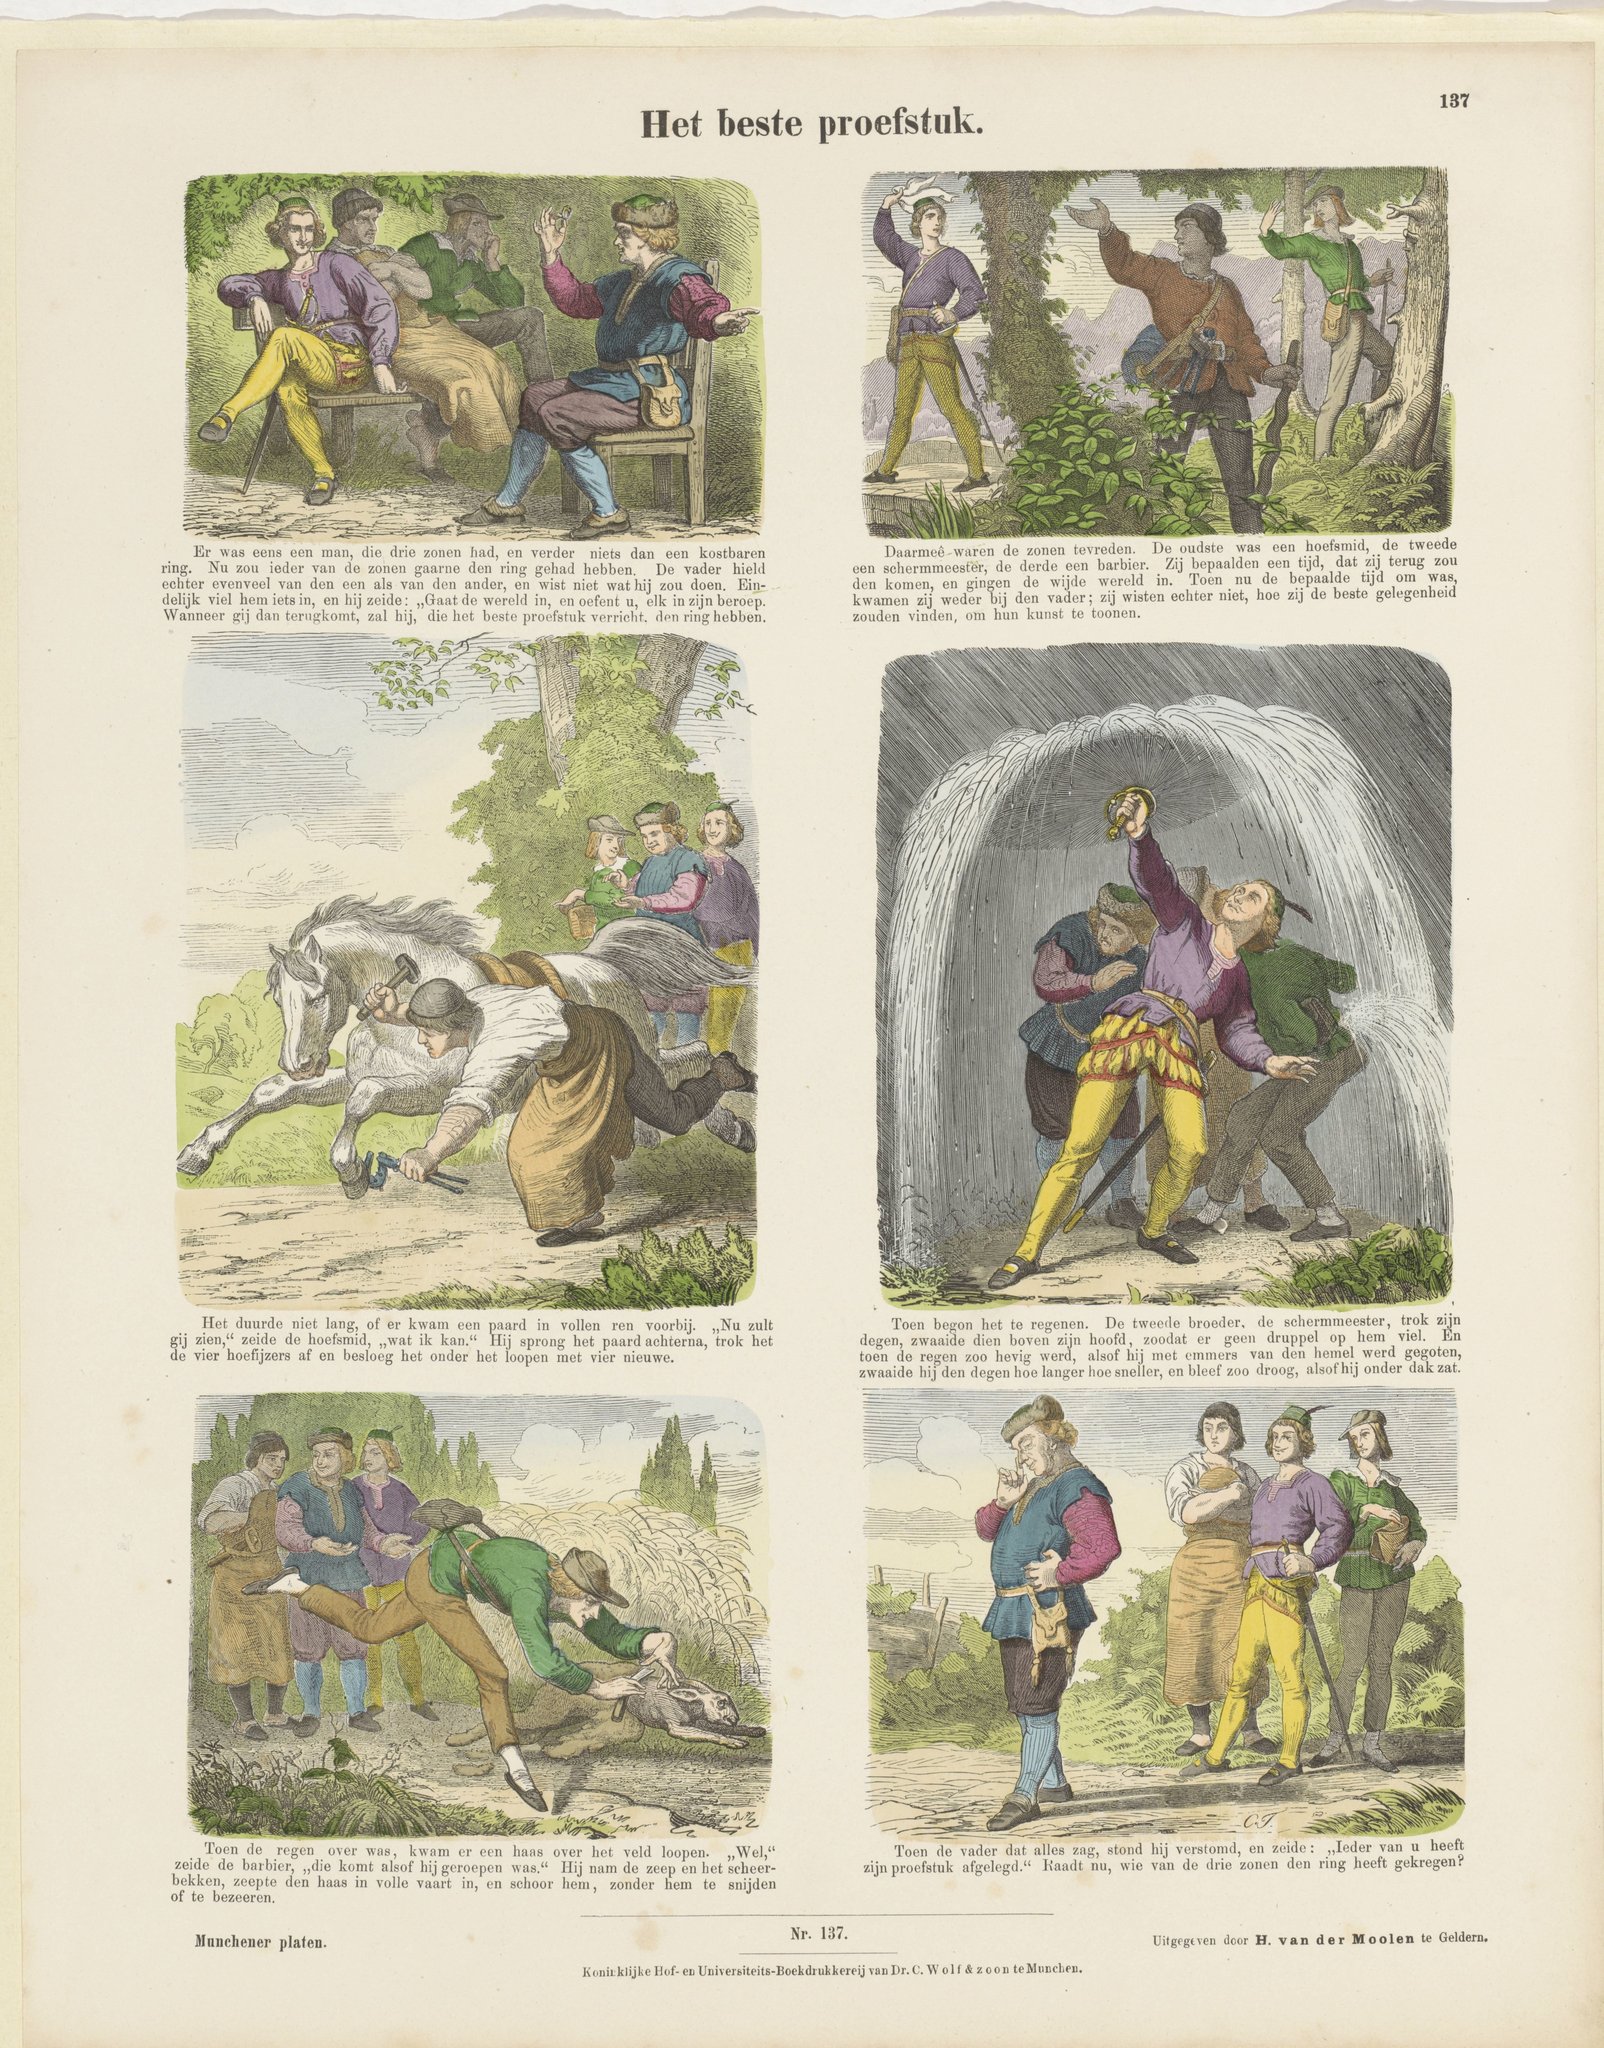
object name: print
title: Het beste proefstuk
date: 1843-1920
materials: paper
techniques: colour, letterpress printing, engraving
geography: munich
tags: craft-production, skilled handiwork, ring, smith, blacksmith, barber, barbershop, horseshoe, fencing (sport)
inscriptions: collector's mark: Lugt 2760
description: Blad met 6 voorstellingen over drie zoons, een schermer, een smid en een barbier die strijden om de ring van hun vader. Onder elke voorstelling een onderschrift. Genummerd midden onder: Nro. 137. Genummerd rechtsboven: 137.